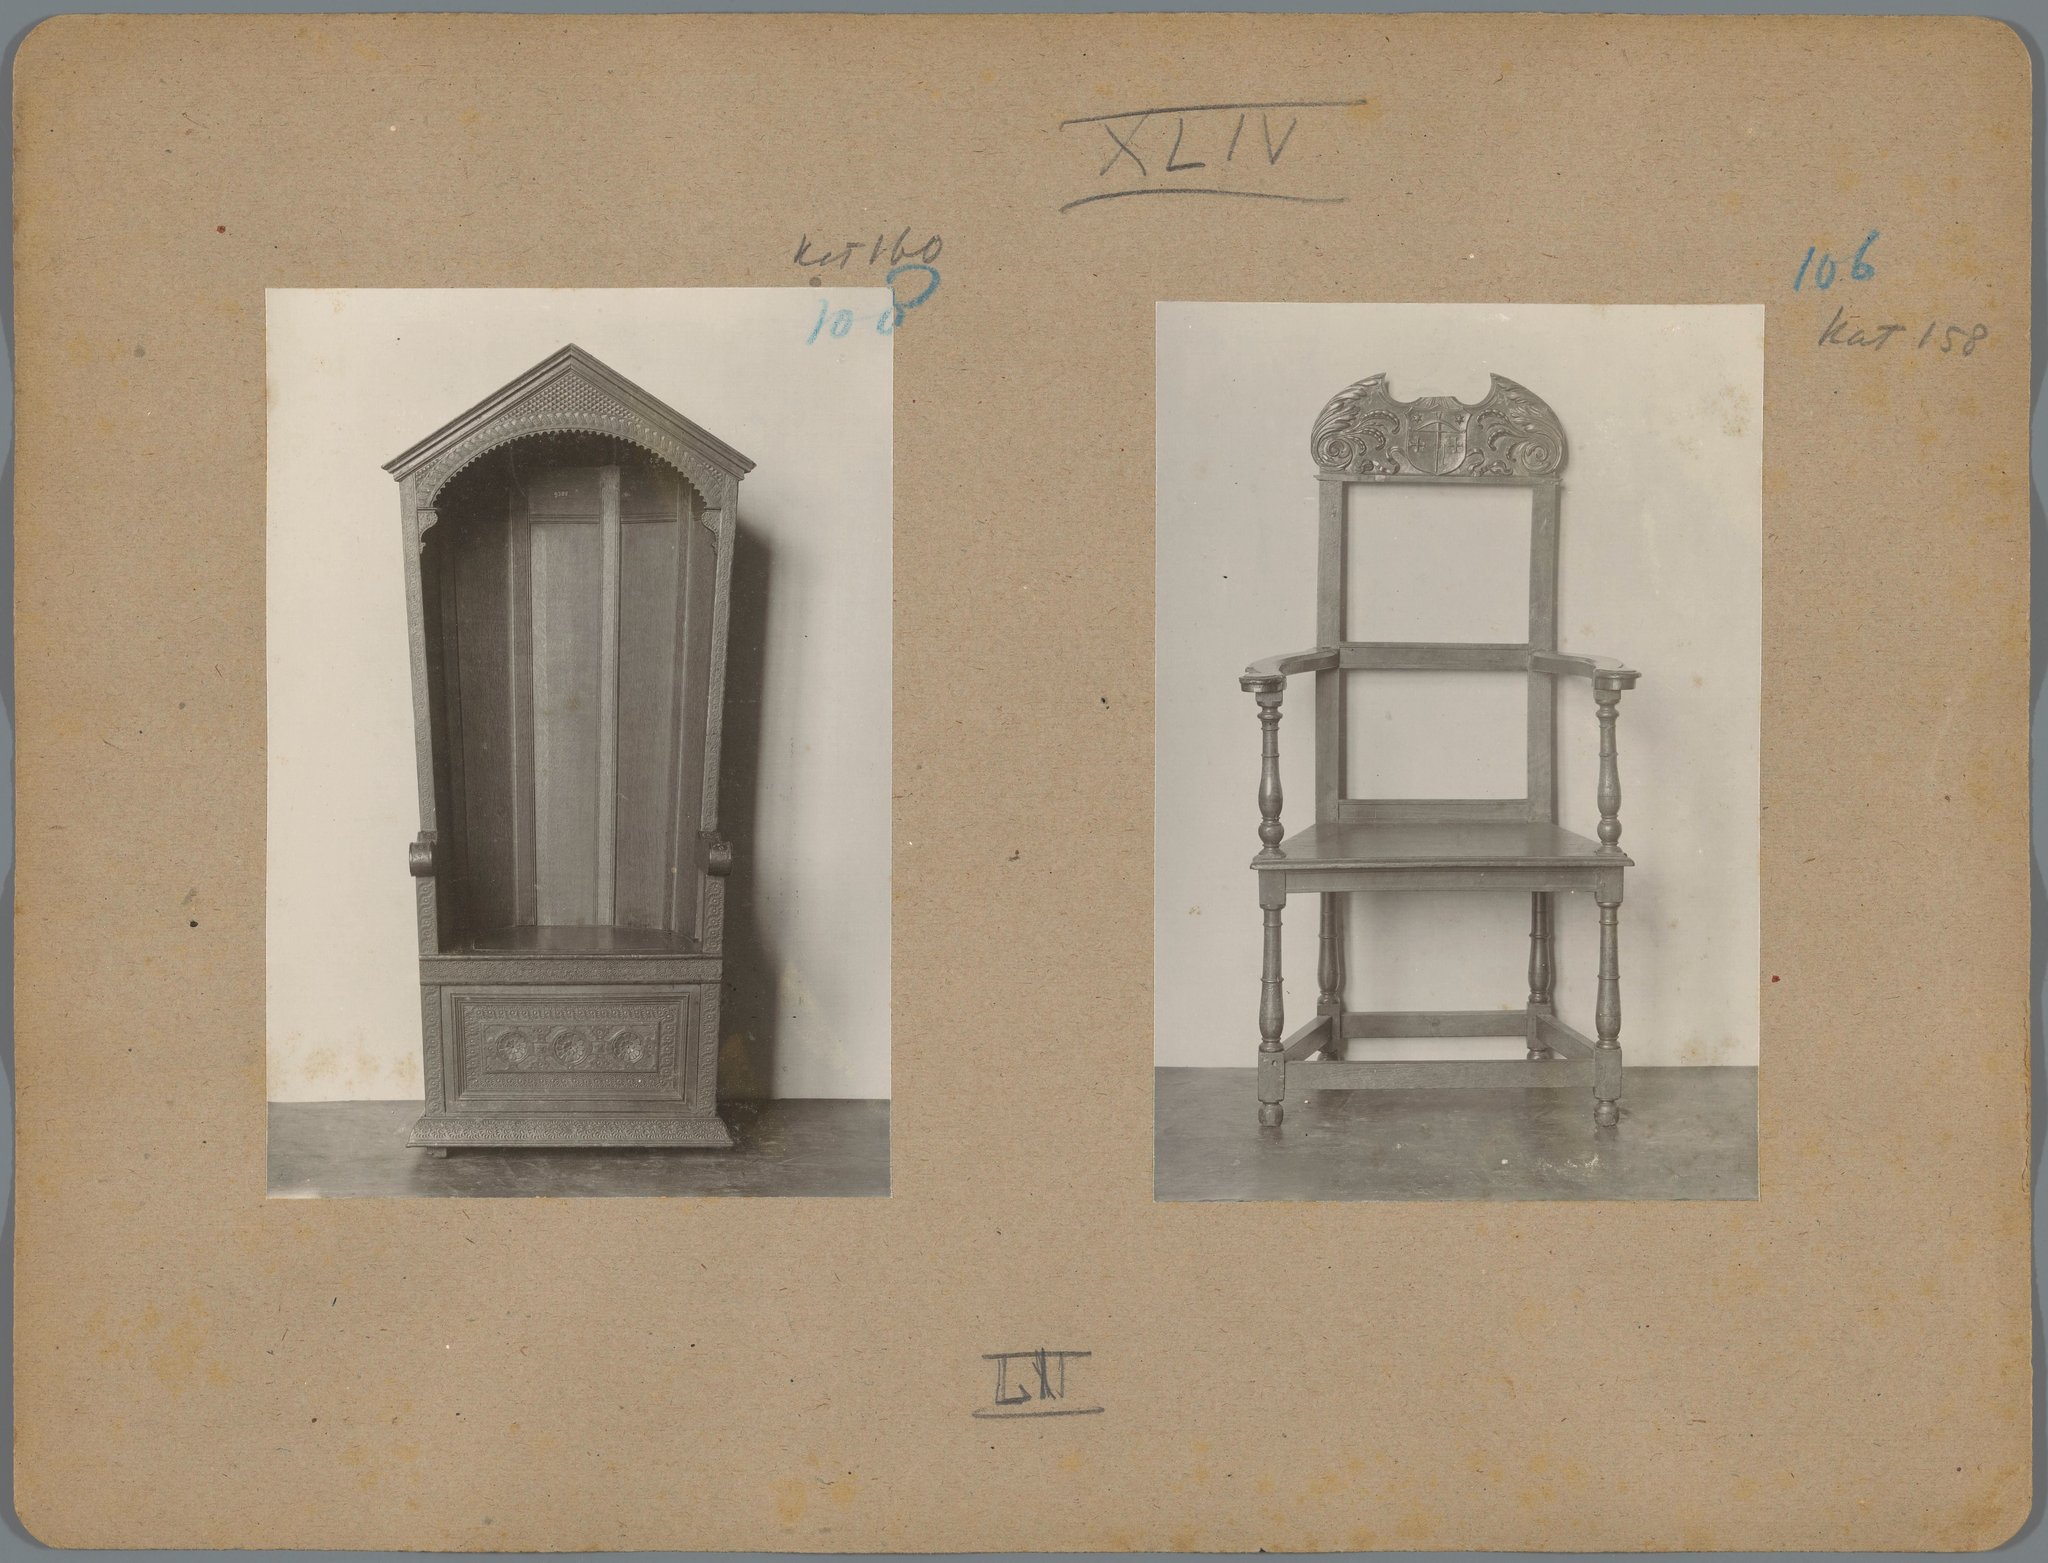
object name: photograph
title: Twee houten stoelen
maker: Anonymous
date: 1875-1900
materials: cardboard, photographic support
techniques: gelatin silver print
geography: europe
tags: coat of arms (as symbol of the state, etc.), armchair, seat, ornament derived from plant forms, europe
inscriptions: number: ‘Kat 158’, number: ‘108’, number: ‘106’, number: ‘XLIV’, collector's mark: ‘KUNSTNIJVERHEIDSCHOOL QUELLINUS AMSTERDAM FRANS HALSSTRAAT 14.’, collector's mark: ‘INSTITUUT VOOR KUNST-NIJVERHEIDSONDERWIJS GABRIËL METSUSTRAAT No. 16 AMSTERDAM’, number: ‘Kat 160’, number: ‘LXI’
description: Links een armstoel met een huifkap, rechts een stoel met op de rugleuning een wapenschild en een plantmotief.